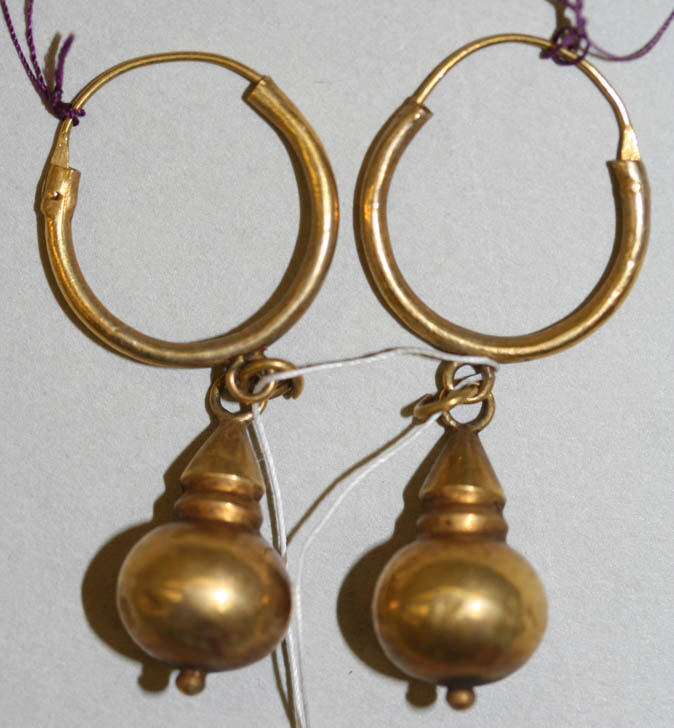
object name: earring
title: Earrings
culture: european, eastern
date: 1701-1900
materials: metal